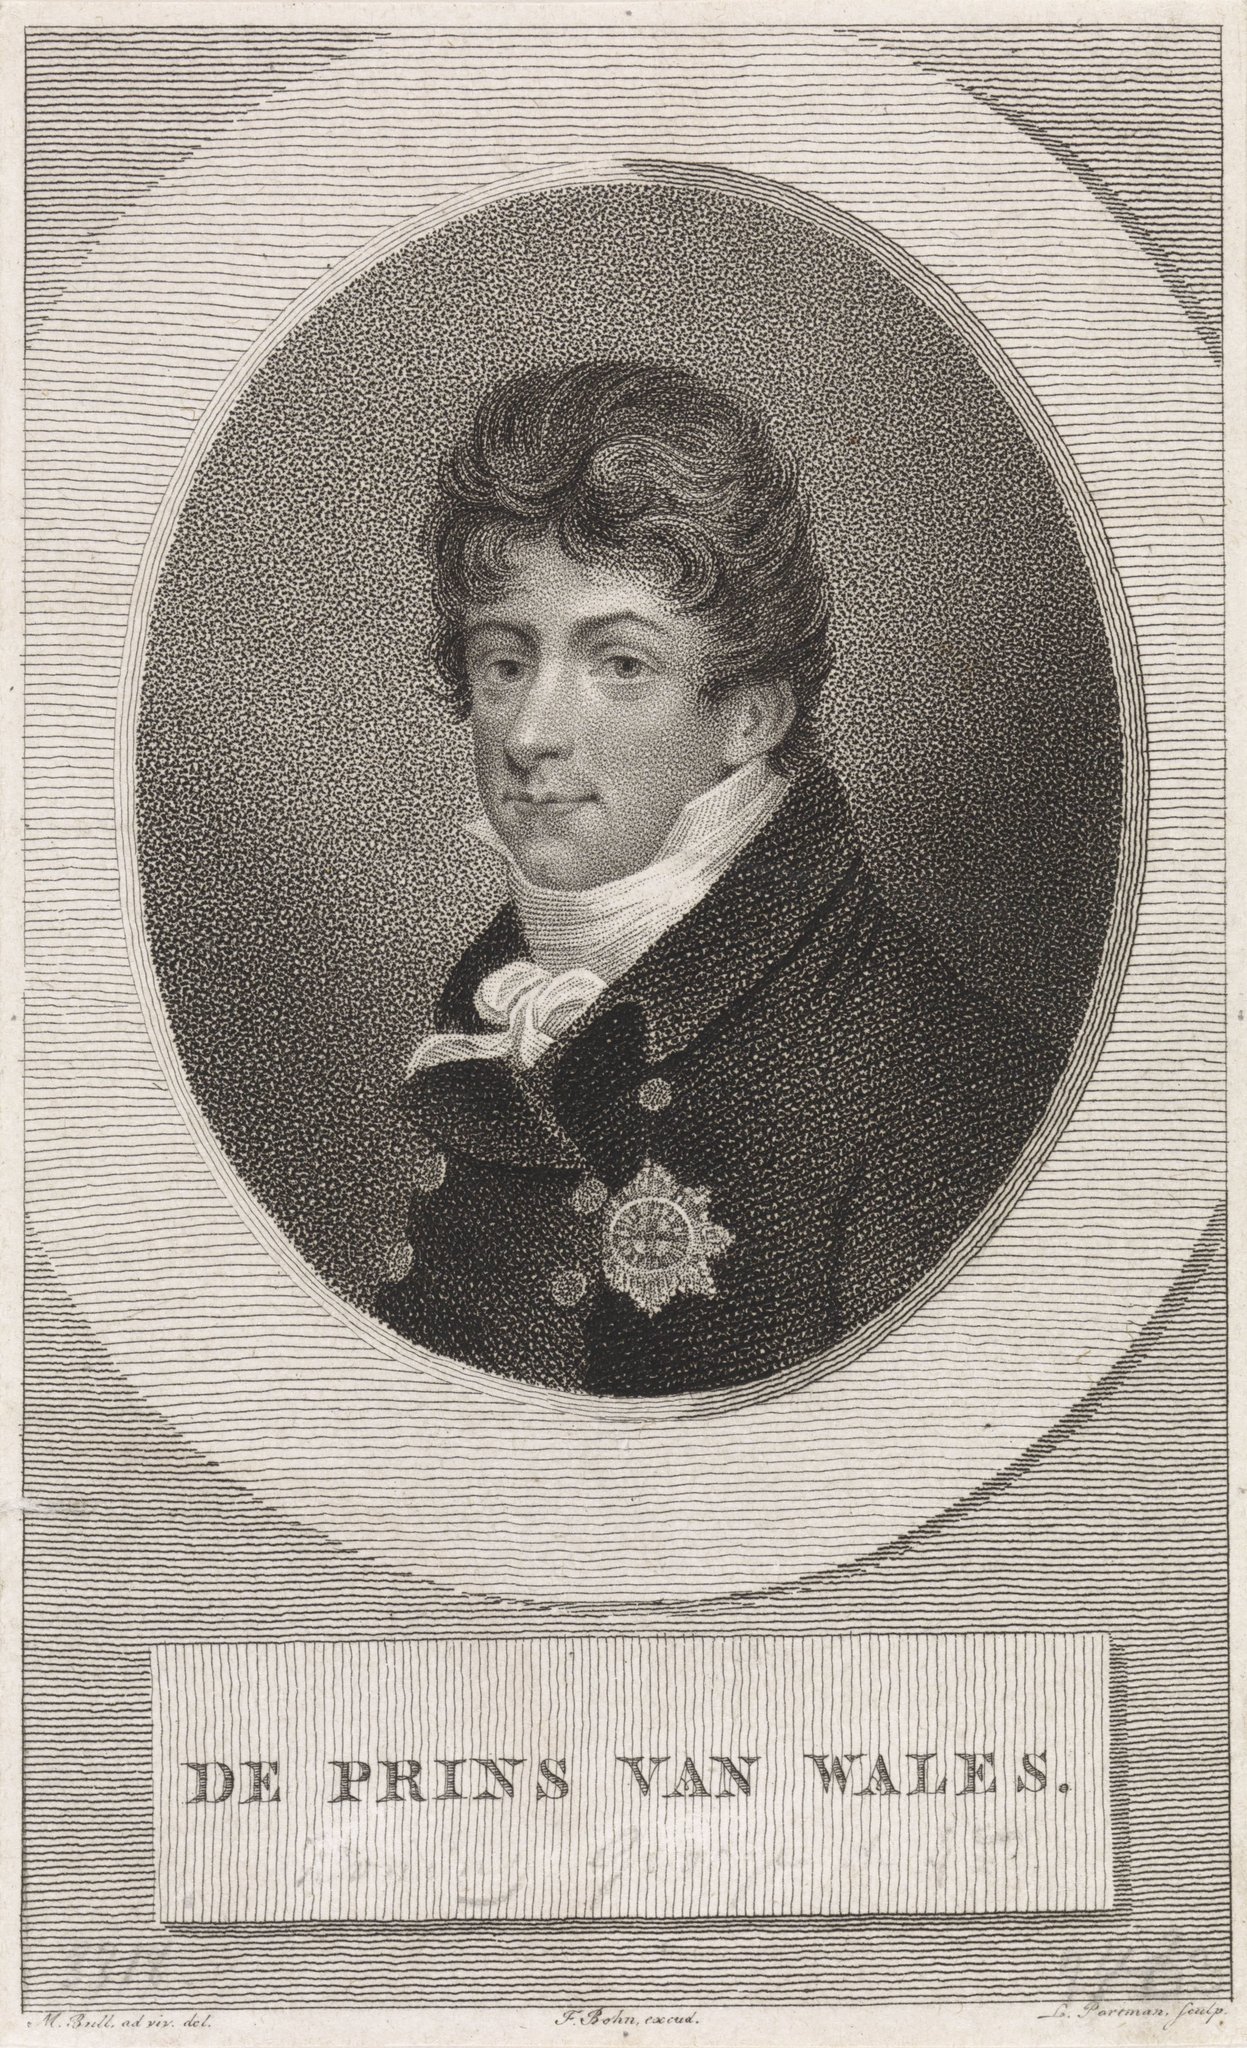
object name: print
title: Portret van George IV, prins van Wales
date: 1787-1828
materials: paper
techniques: etching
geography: amsterdam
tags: george iv (koning van het verenigd koninkrijk), armorial bearing, heraldry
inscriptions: collector's mark: Lugt 1337, collector's mark: Lugt 2228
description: Op zijn jas draagt hij het teken van de Orde van de Kousenband.